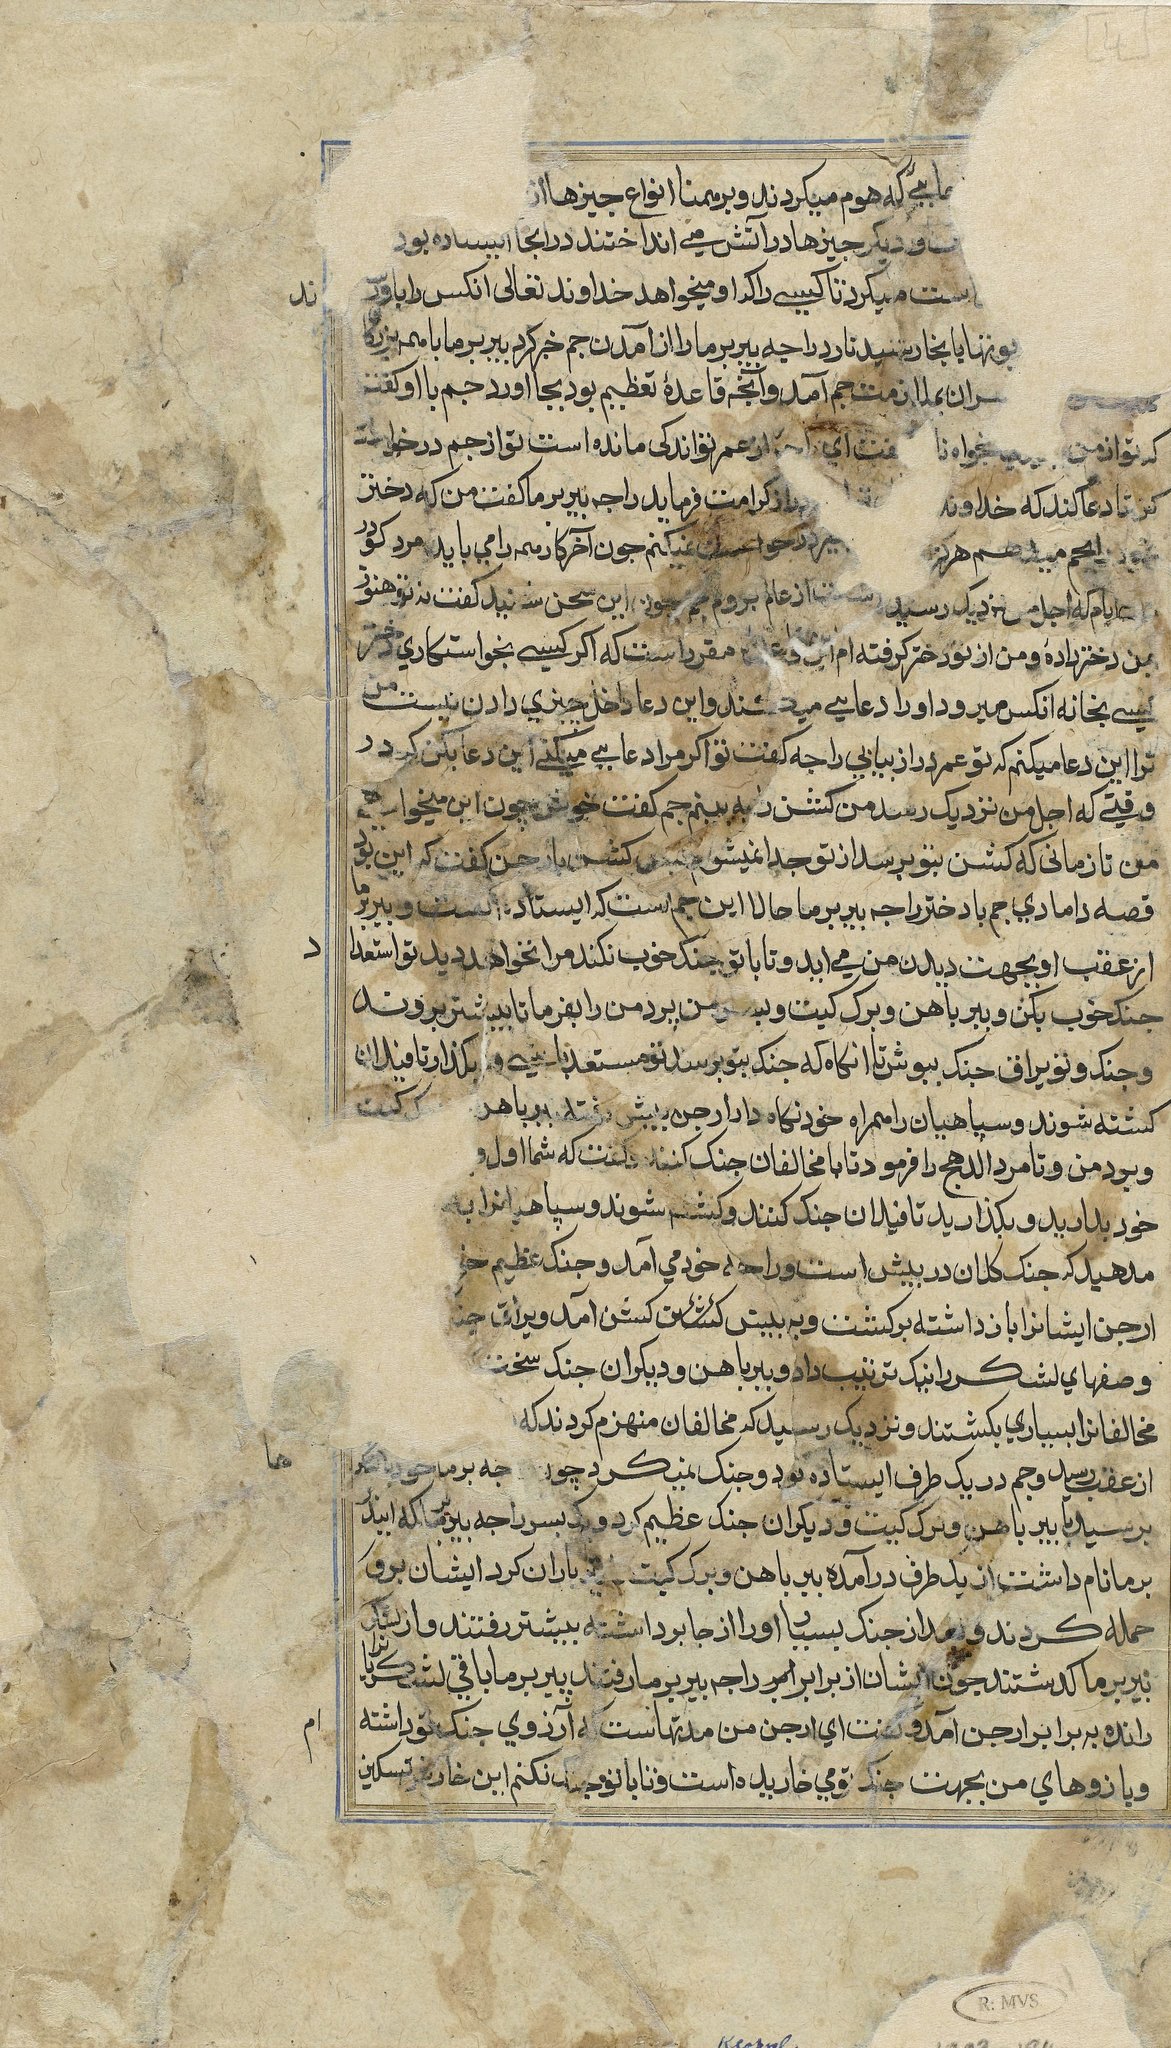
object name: tekst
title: Tekstblok Razm Nama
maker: Anonymous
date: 1616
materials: paper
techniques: brush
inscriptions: inscription